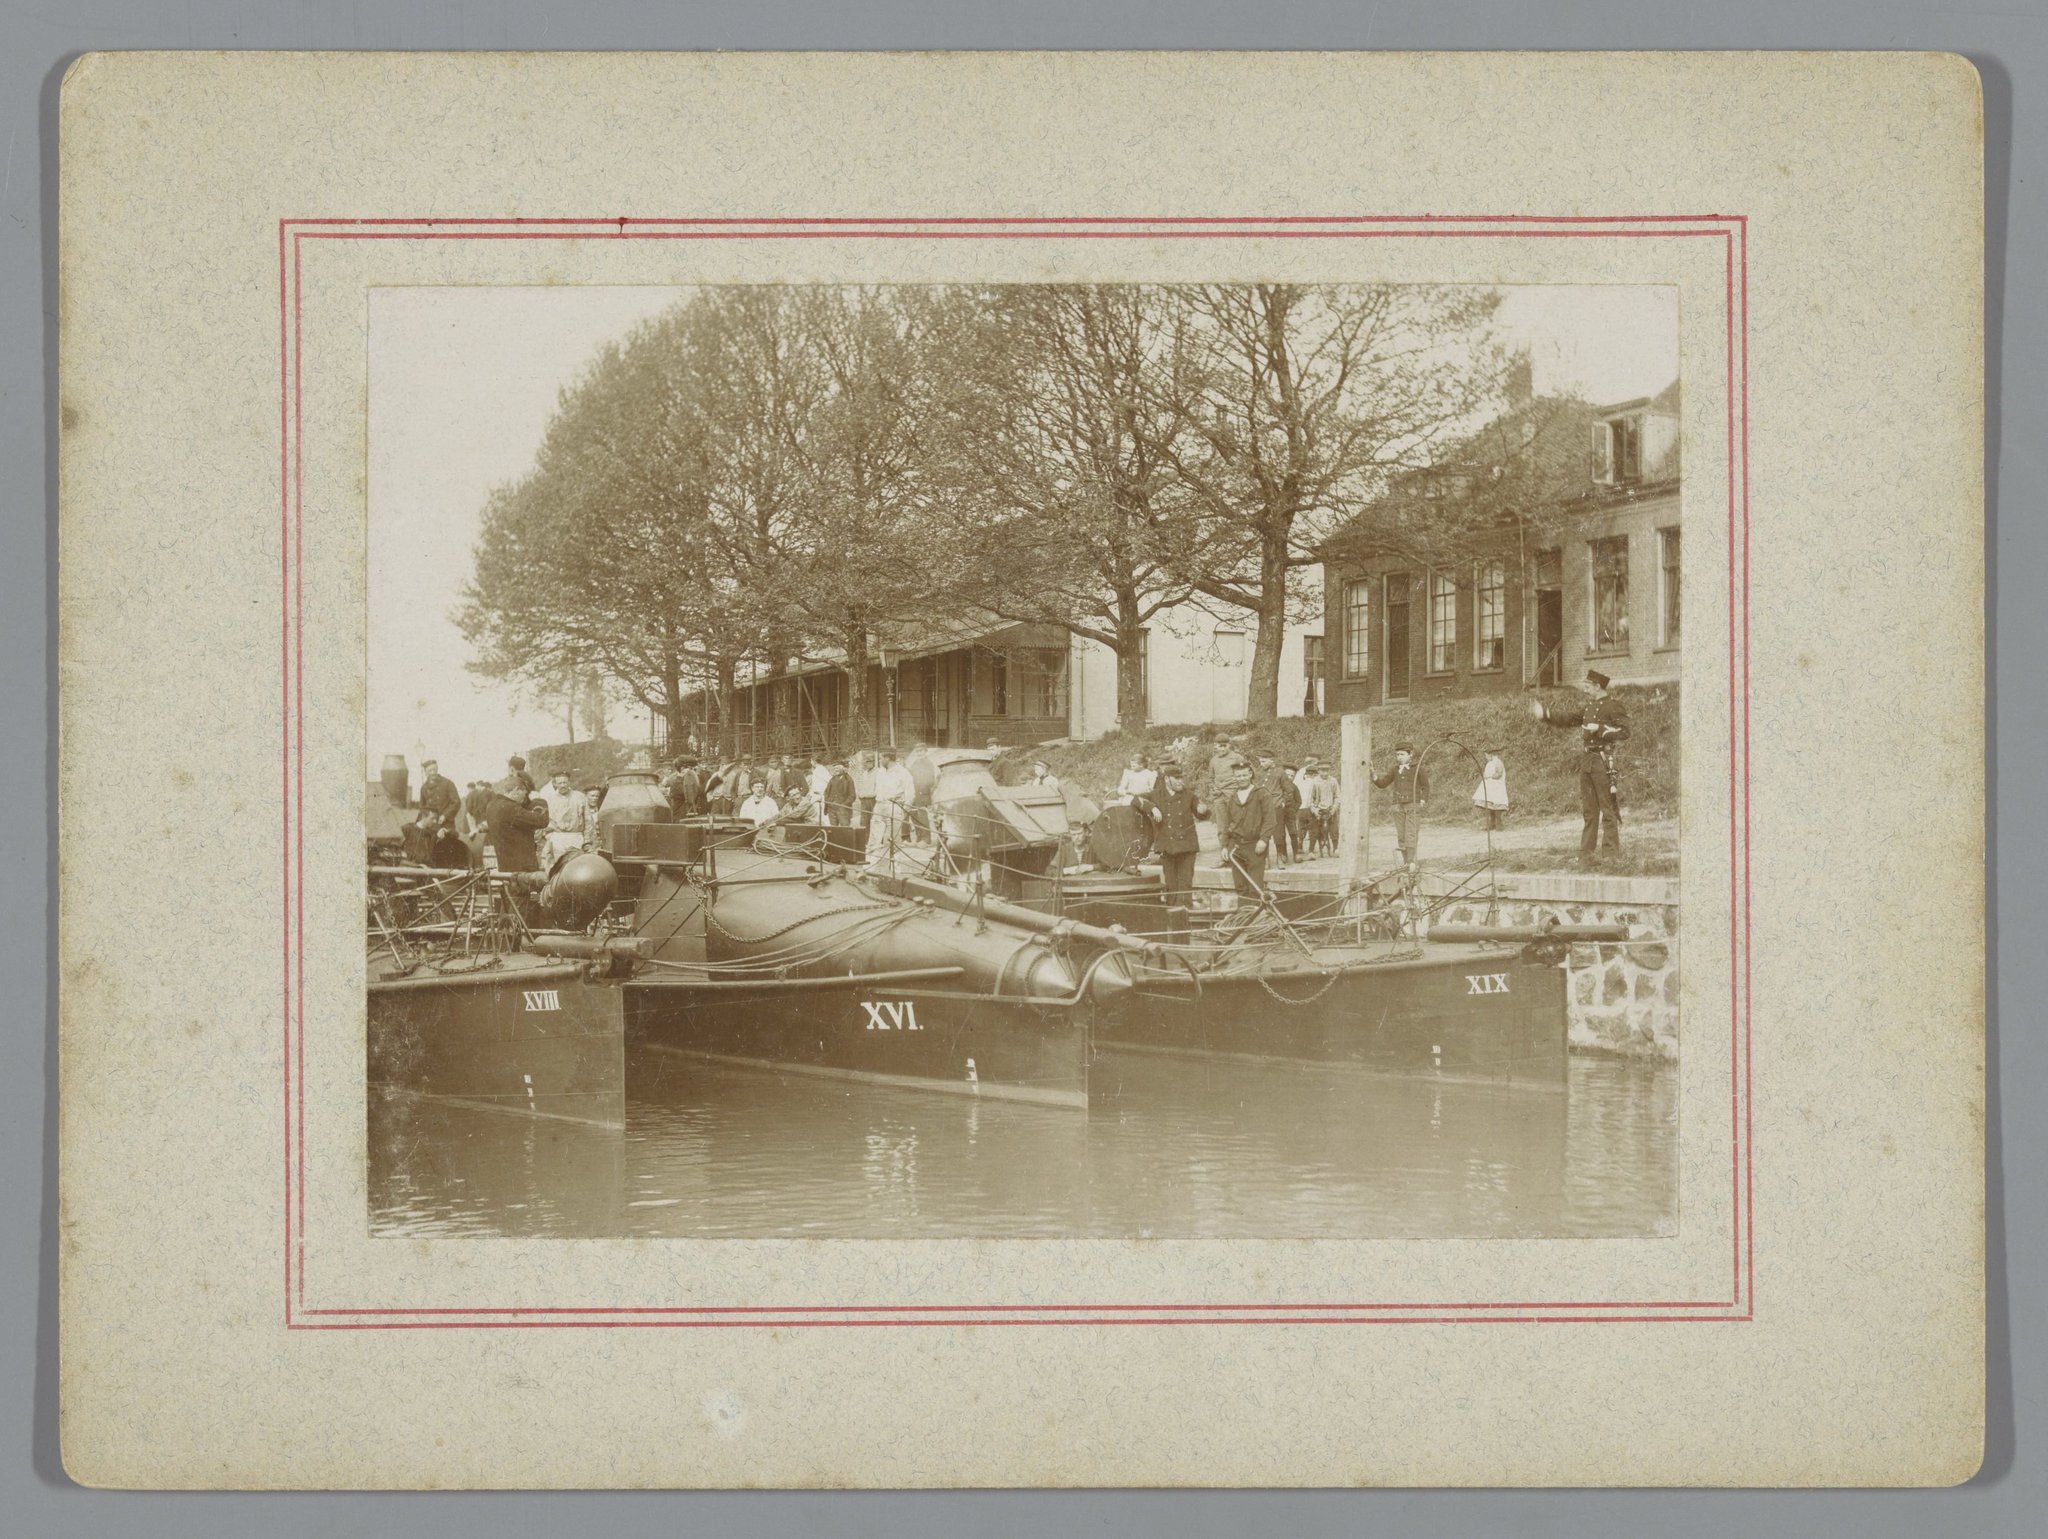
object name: photograph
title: Boten langs een kade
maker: Anonymous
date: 1895-1910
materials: cardboard, photographic support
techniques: gelatin silver print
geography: netherlands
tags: canal, quay